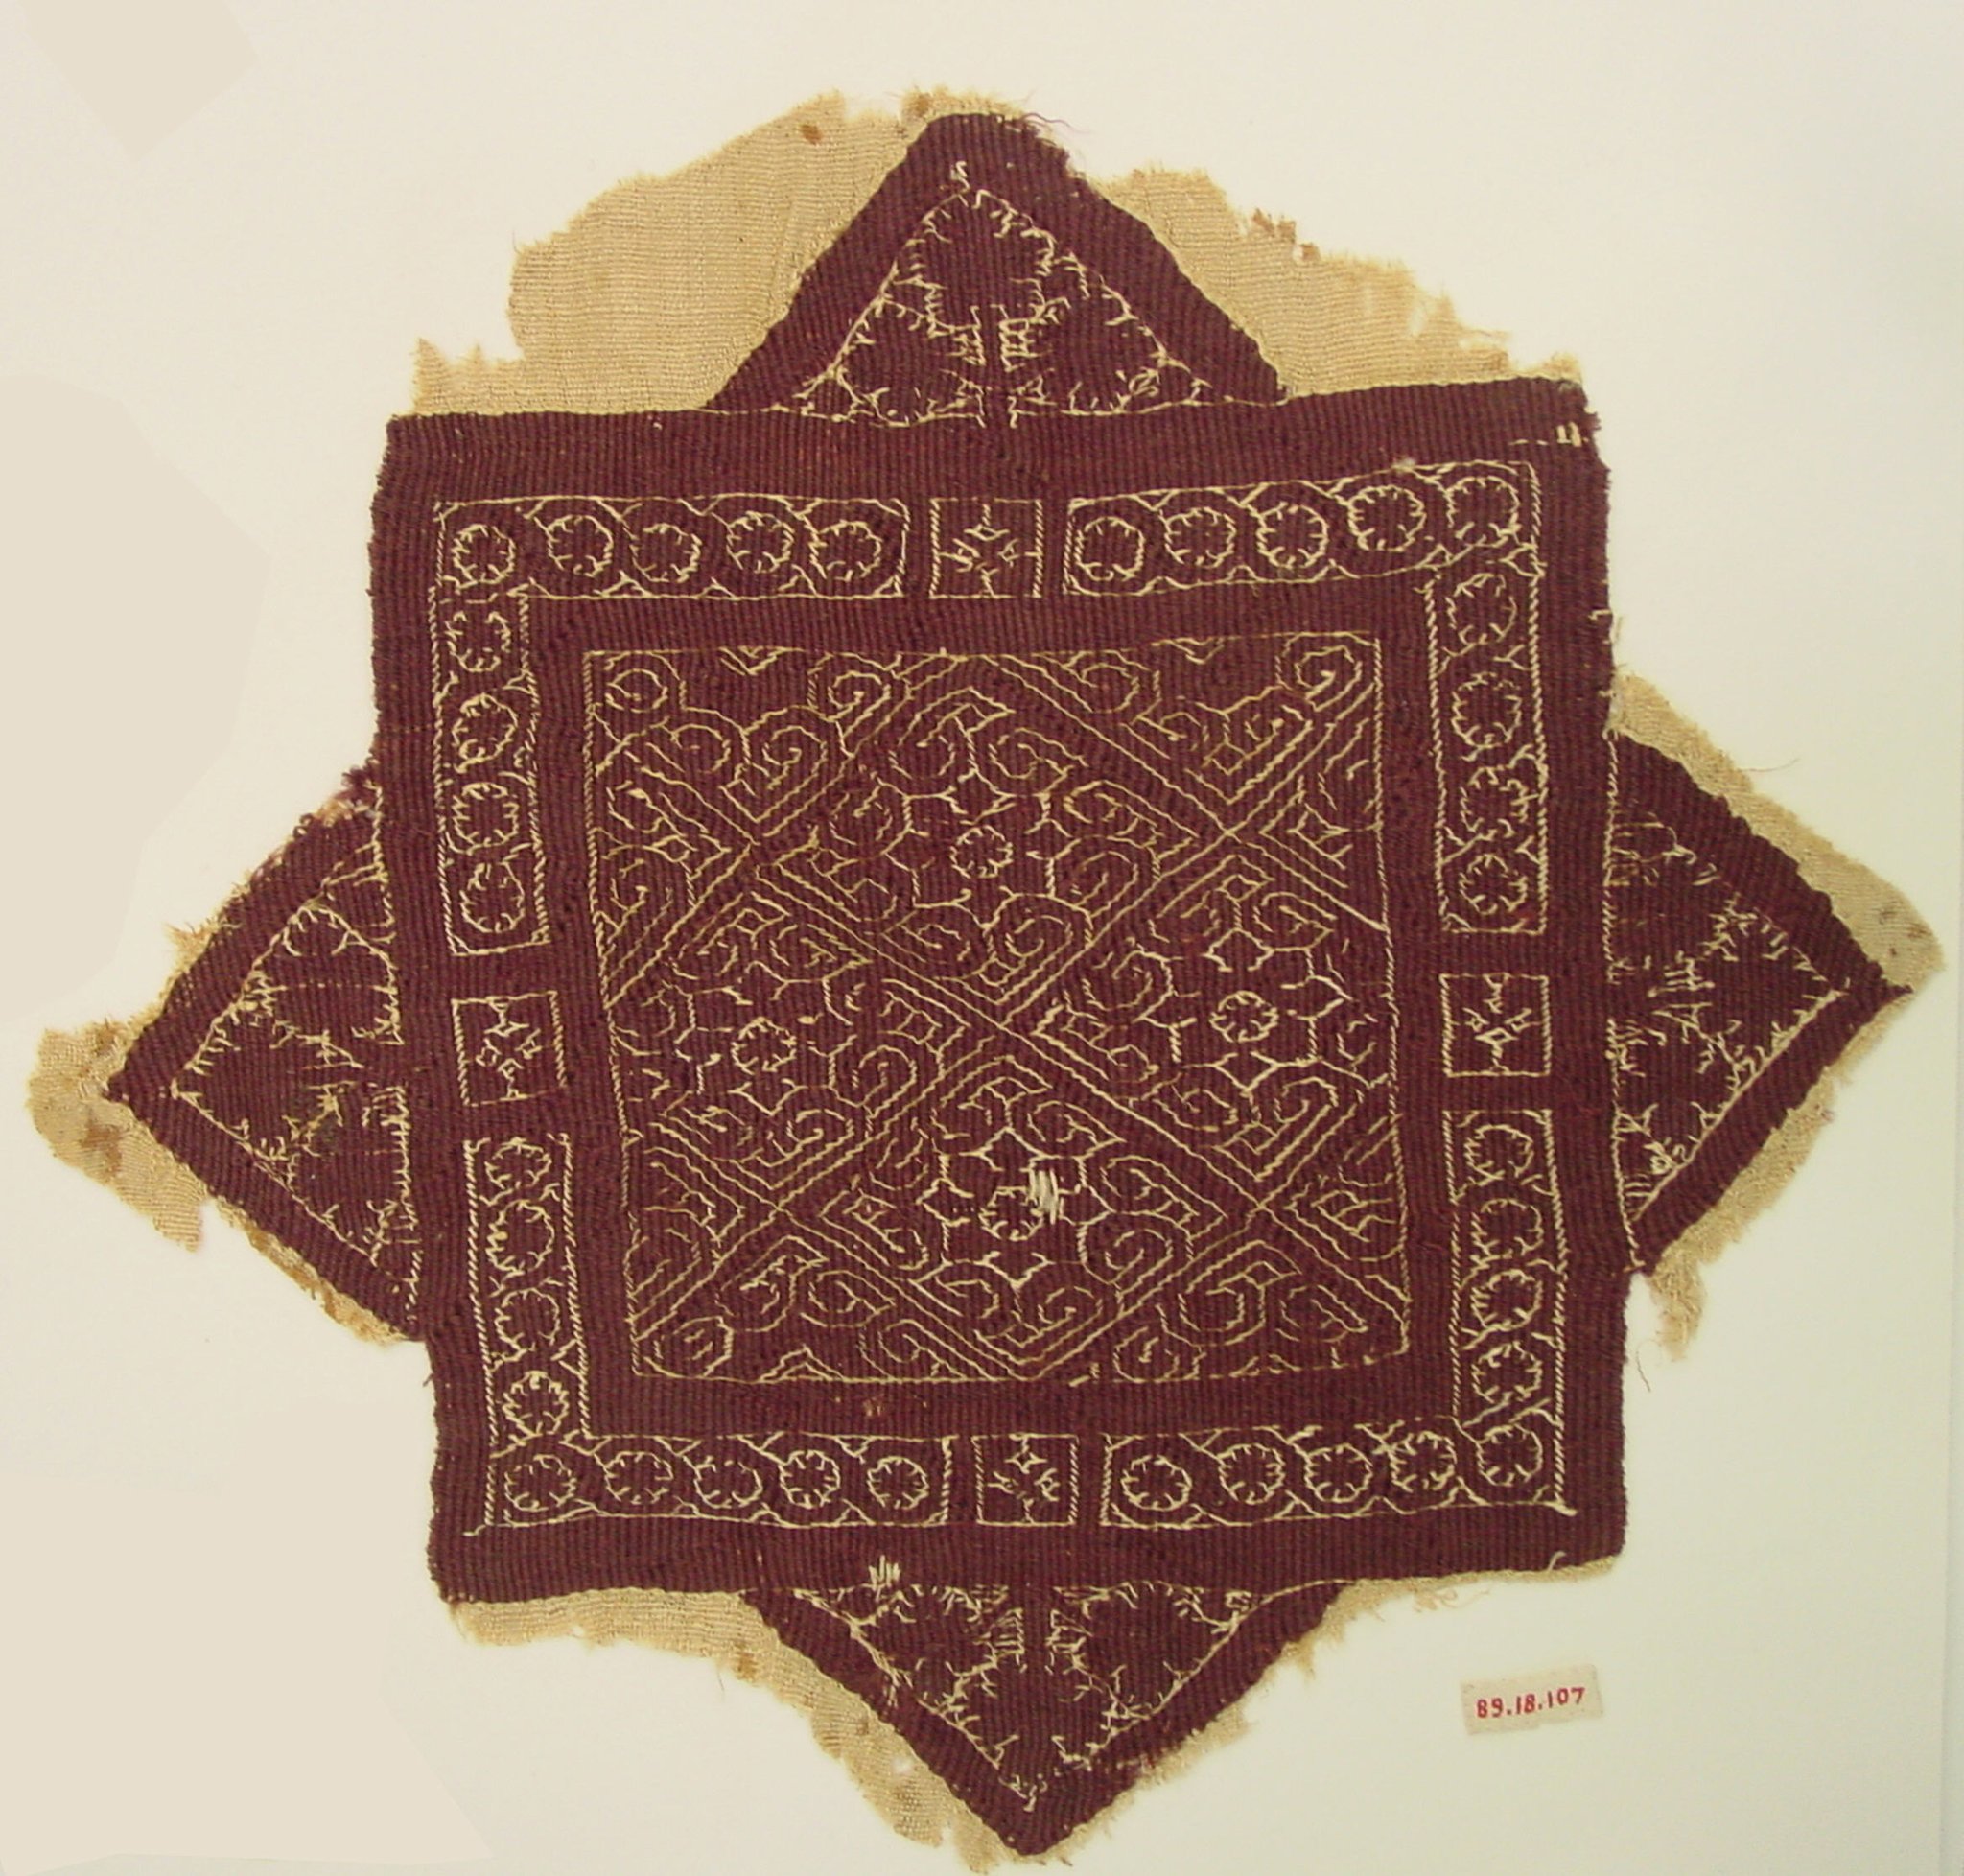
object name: textile fragment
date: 201-400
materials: linen, wool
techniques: weave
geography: egypt